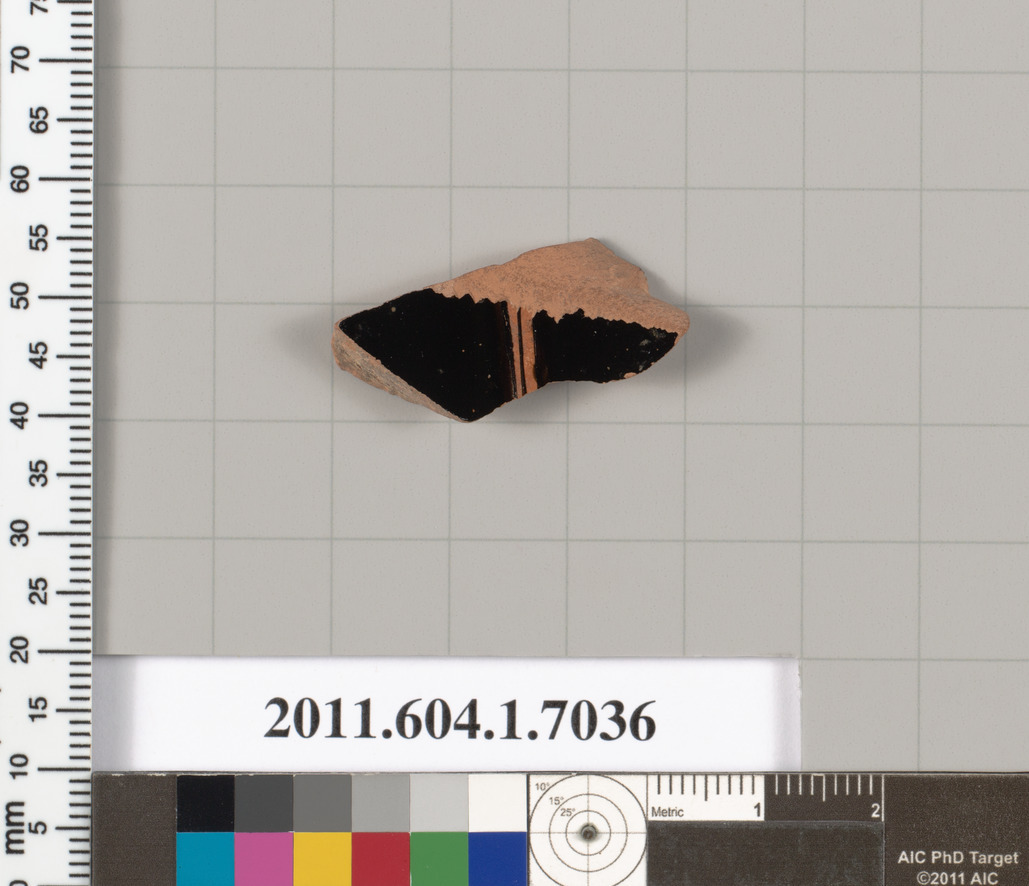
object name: kylix fragment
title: Terracotta fragment of a kylix (drinking cup)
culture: greek, attic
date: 500-480 BCE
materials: terracotta